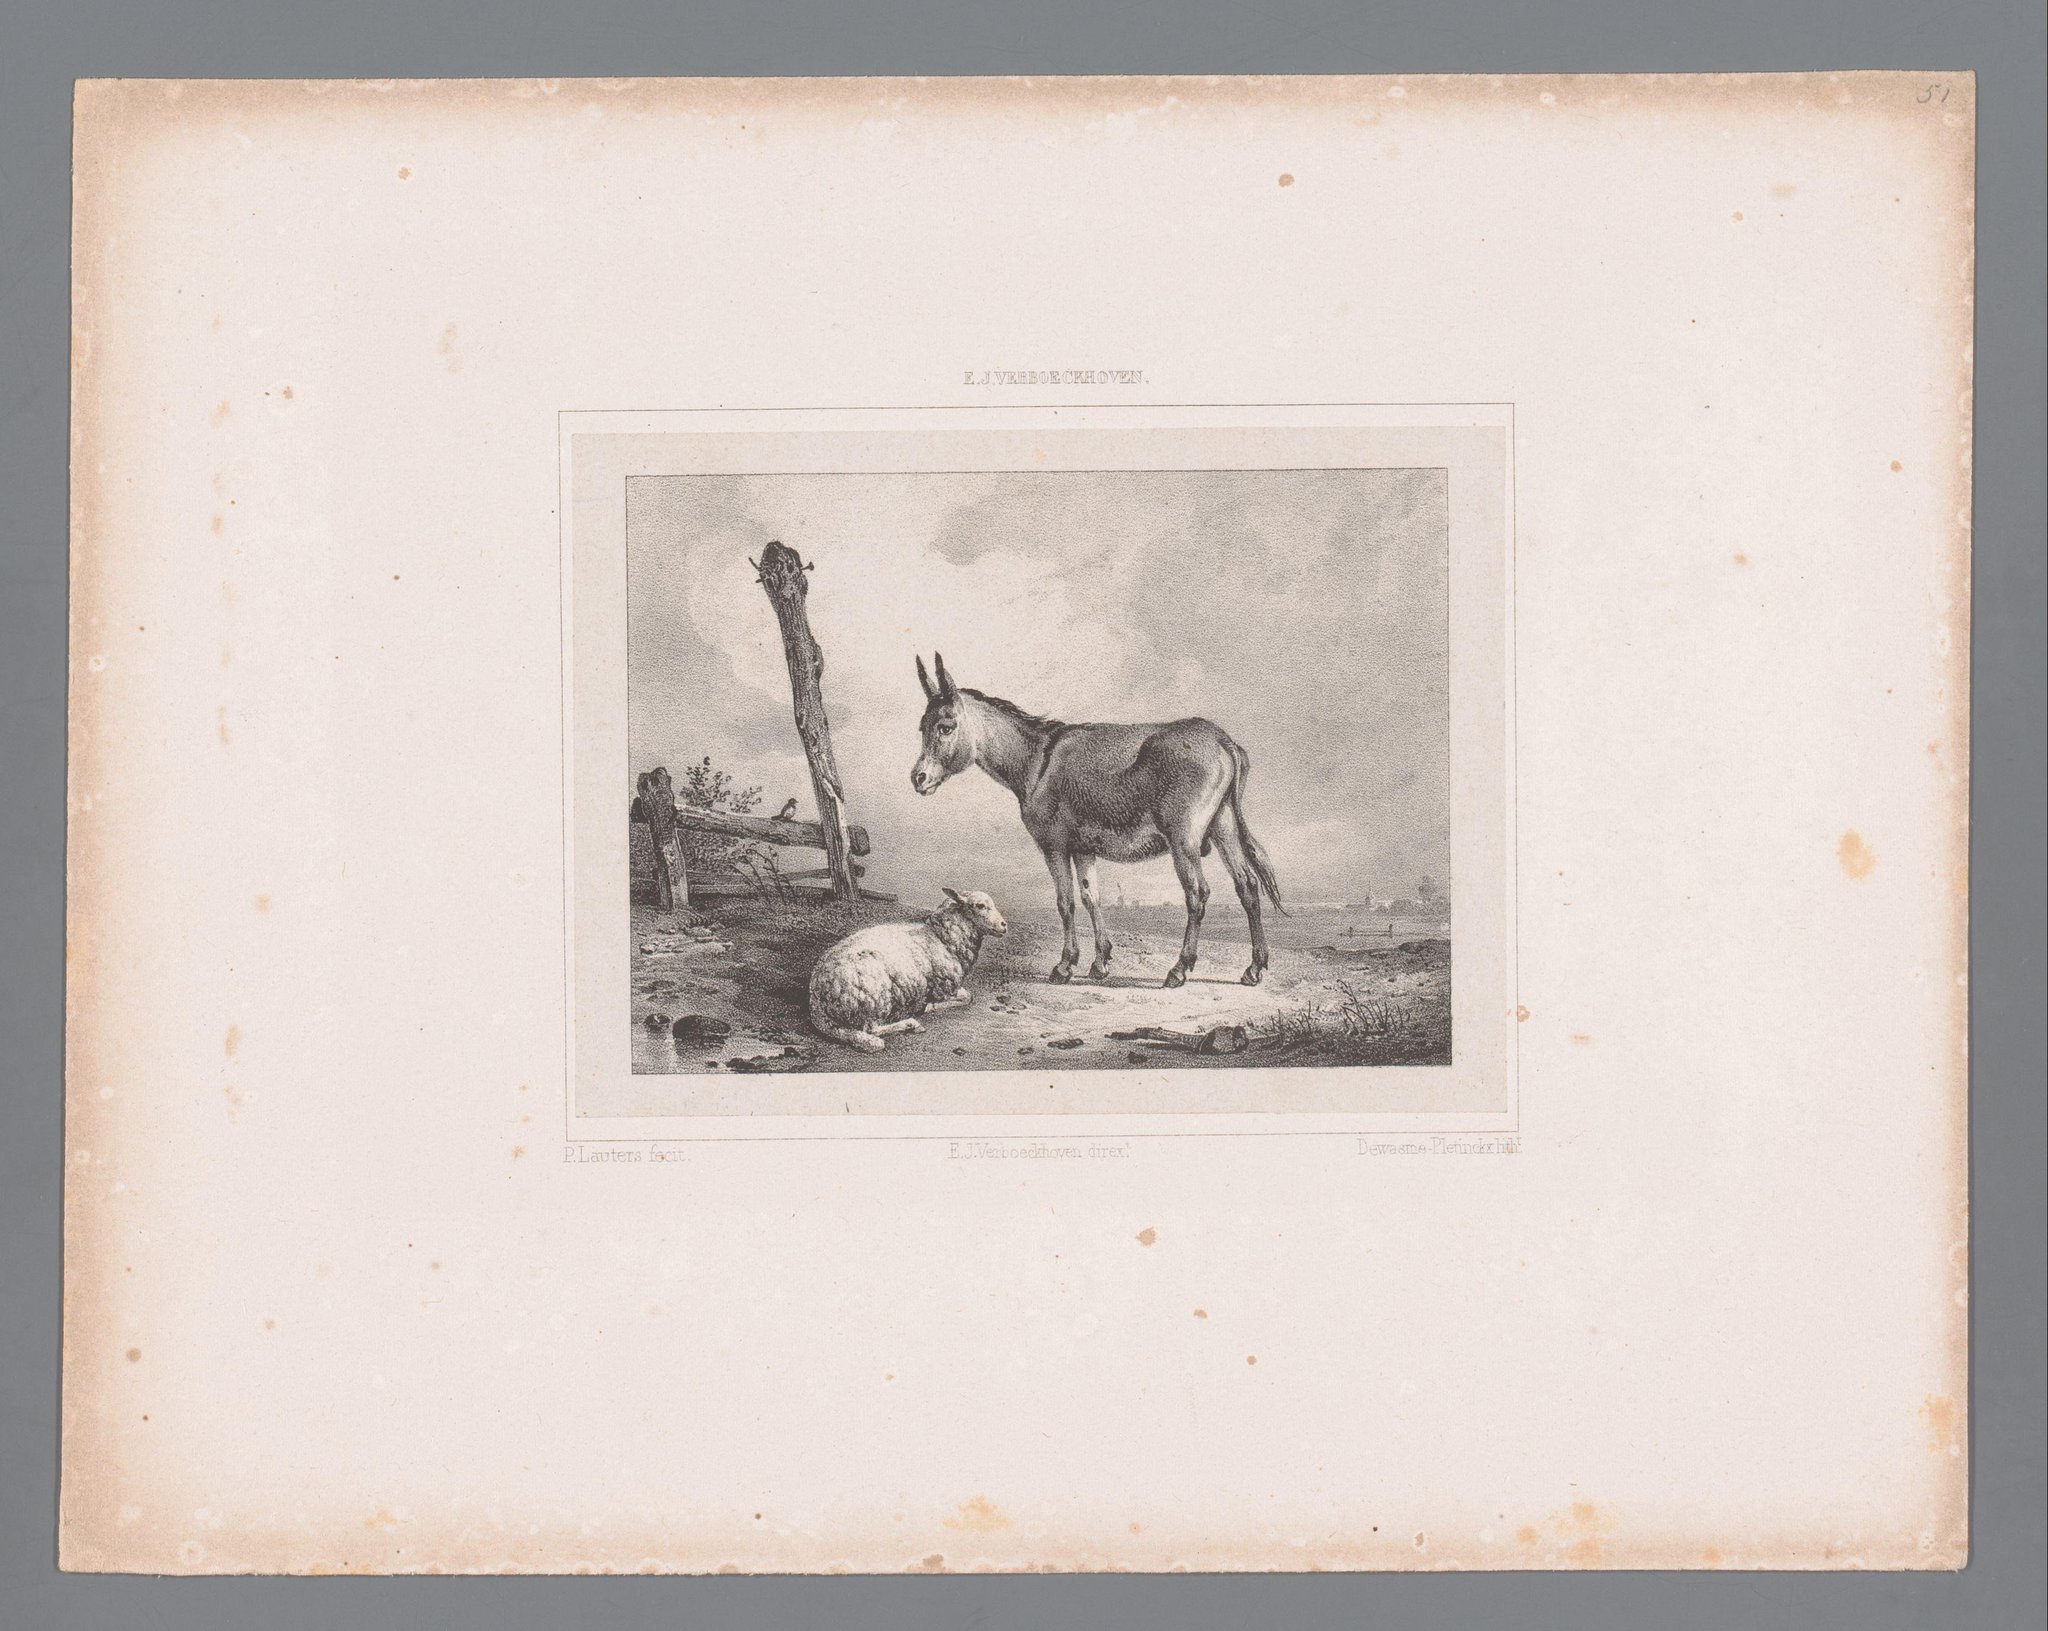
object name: print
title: Album lithographié par Paul Lauters d'après les dessins des principaux peintres du Royaume des Pays-Bas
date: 1829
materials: paper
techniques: lithograph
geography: brussels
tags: ass, donkey, sheep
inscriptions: collector's mark: Lugt 2233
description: Prent verschenen in: Verboeckhoven, Eugène. Album lithographié par Paul Lauters d'après les dessins des principaux peintres du Royaume des Pays-Bas. Brussel: Antoine Dewasme-Pletinckx, 1829.